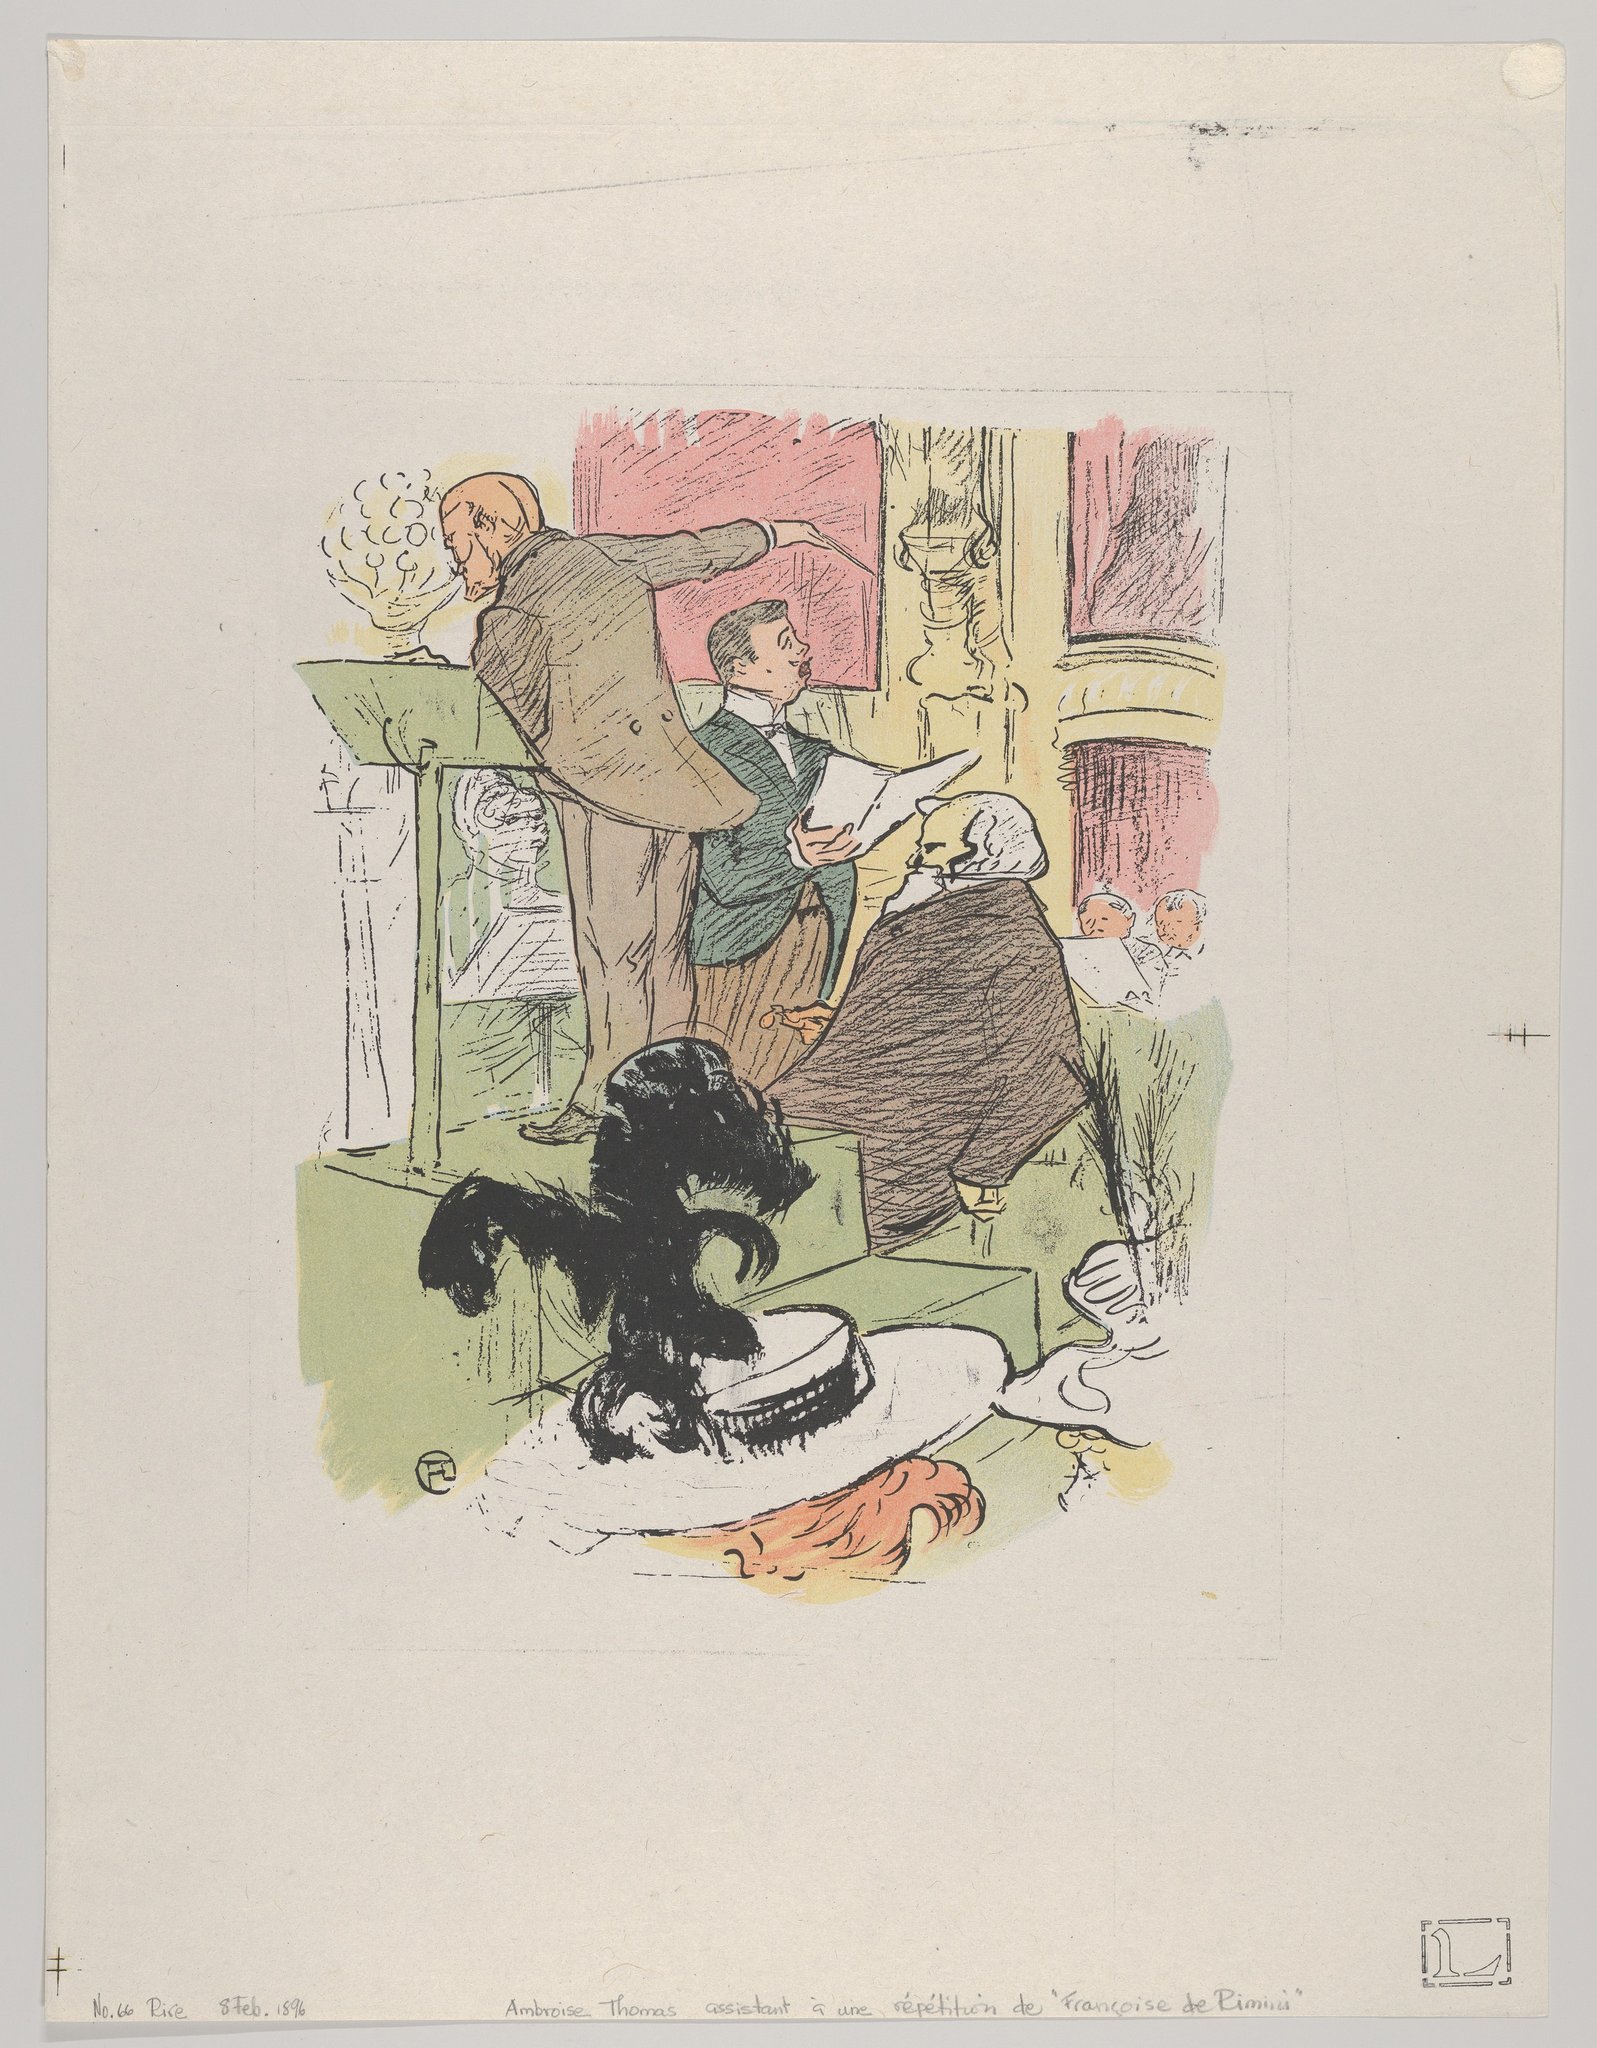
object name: print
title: Ambroise Thomas assistant à une répétition de Françoise de Rimini, from Le Rire, No. 66, 8 February 1896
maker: henri de toulouse-lautrec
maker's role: artist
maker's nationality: french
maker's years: 1864-1901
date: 1896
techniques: lithograph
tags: men